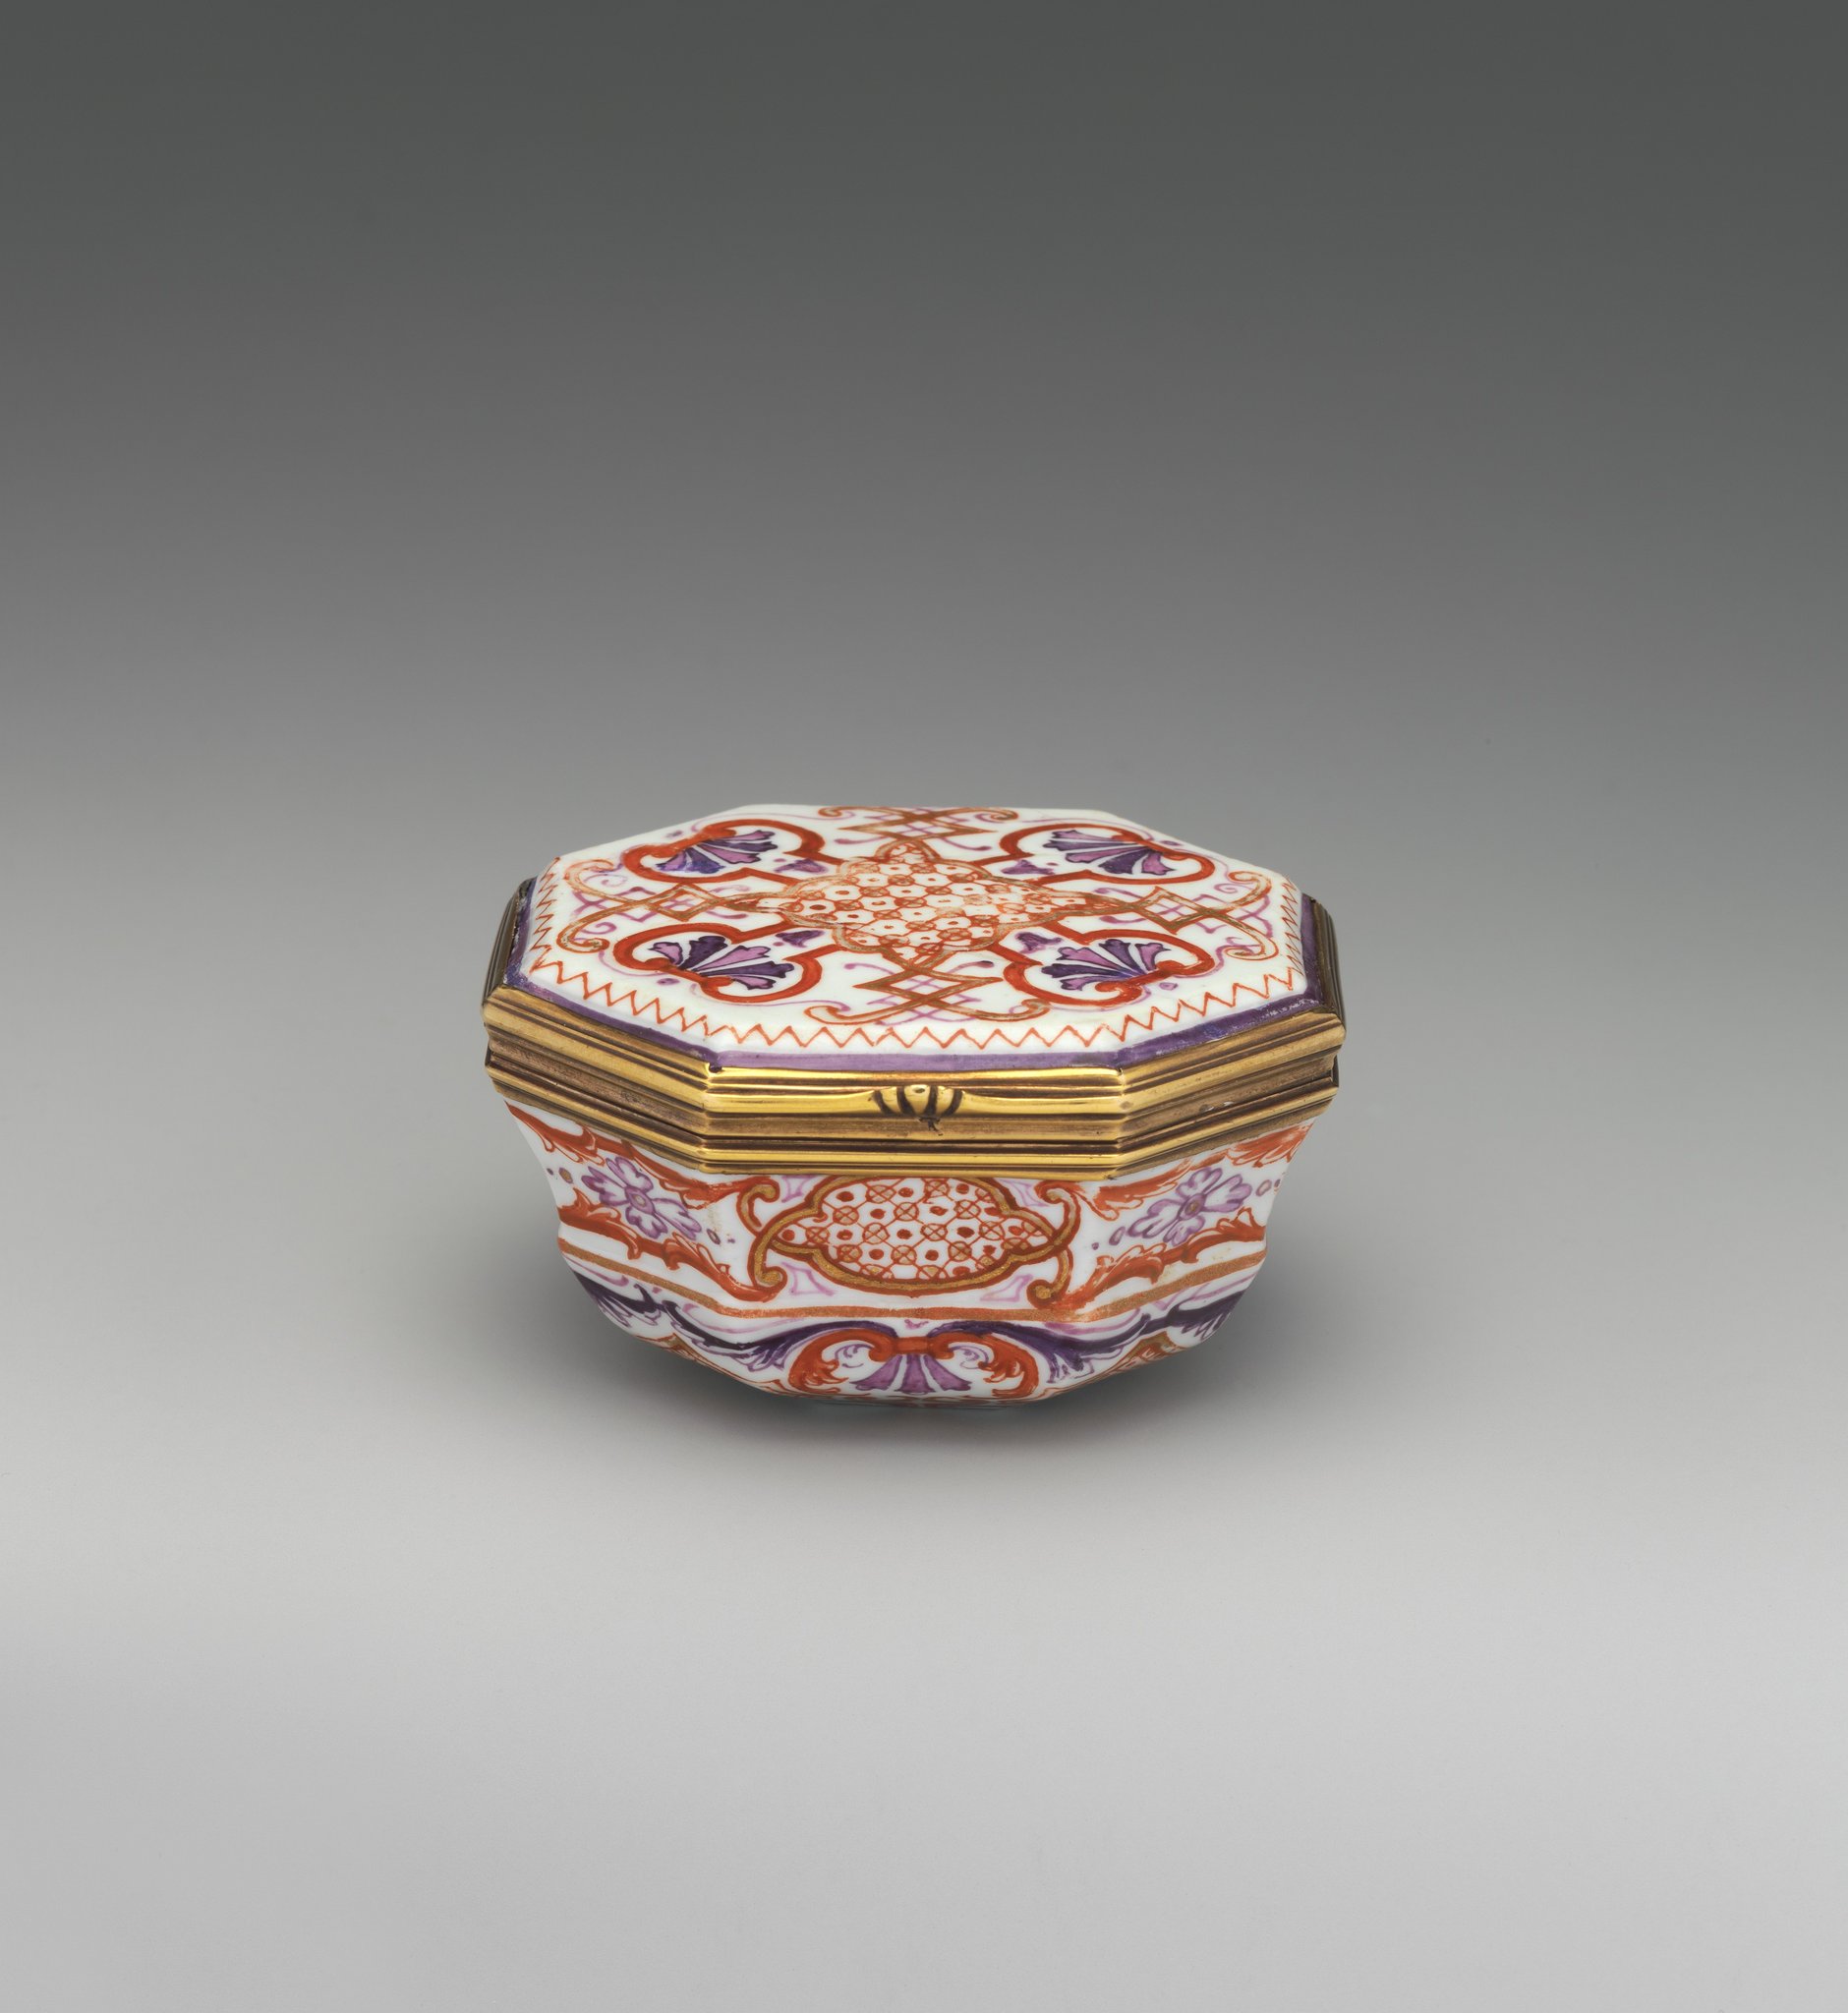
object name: snuffbox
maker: vienna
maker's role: manufactory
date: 1730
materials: gold, hard paste porcelain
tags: flowers